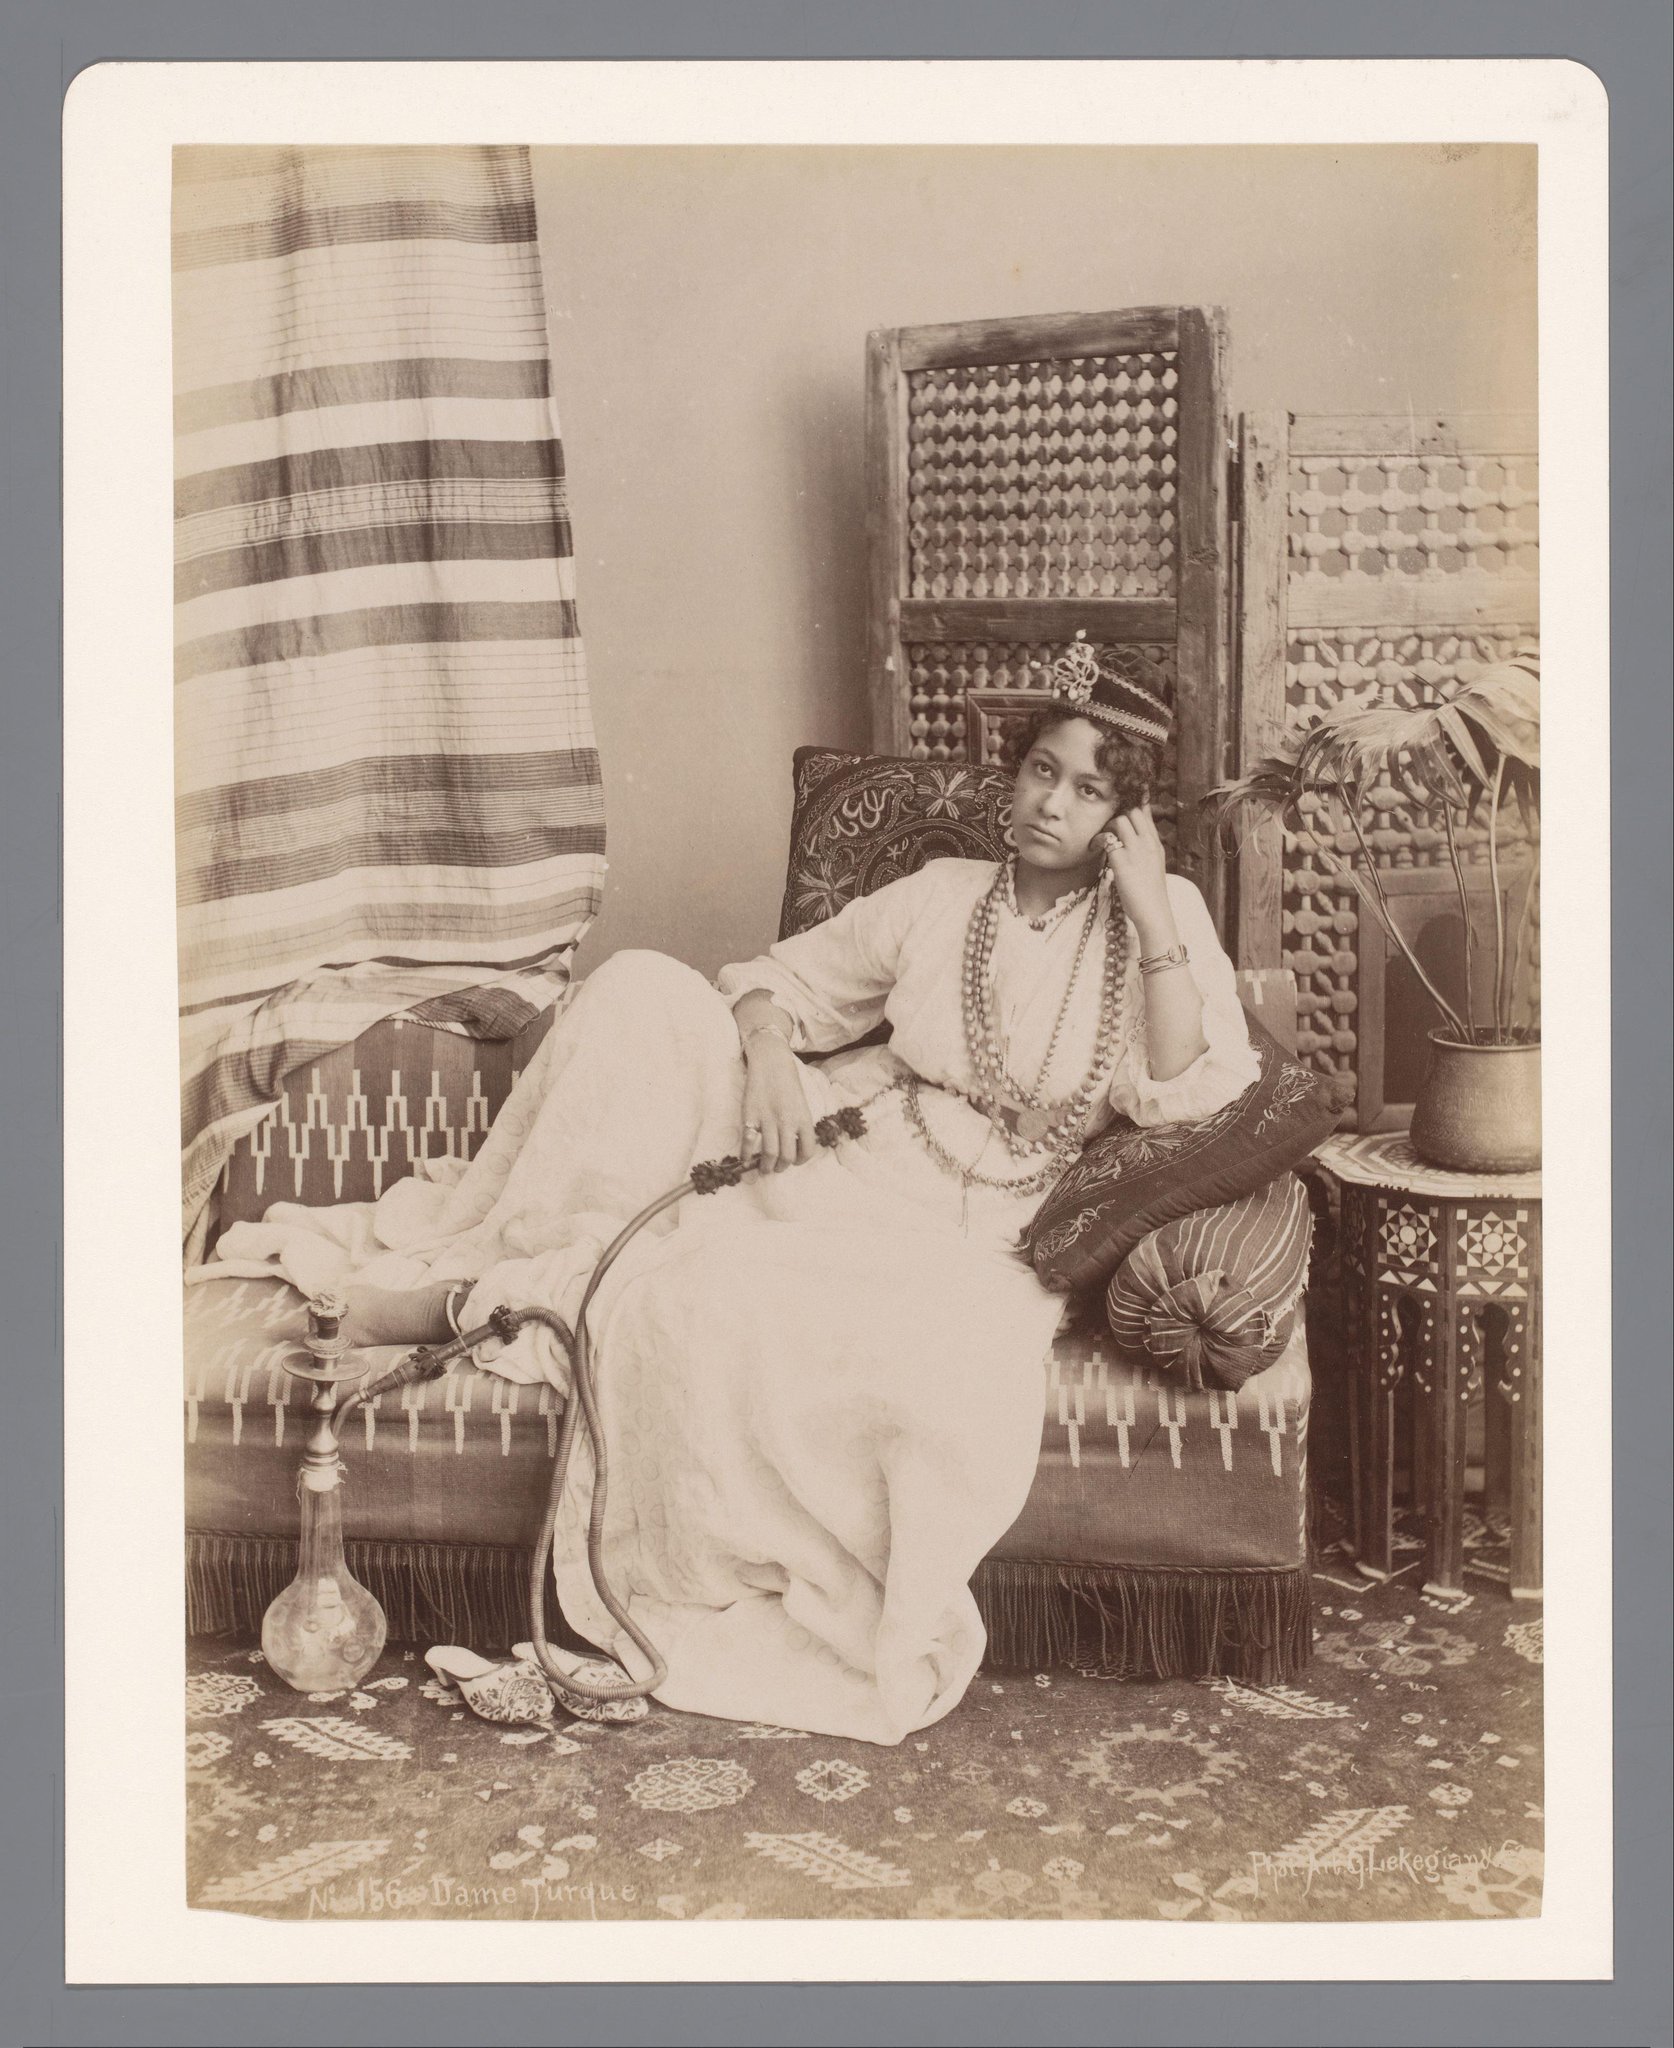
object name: photograph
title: Portret van een onbekende Turkse vrouw met waterpijp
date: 1887-1900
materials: paper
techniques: albumen print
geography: middle east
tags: adult woman, anonymous historical person portrayed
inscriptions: number: ‘No 156’